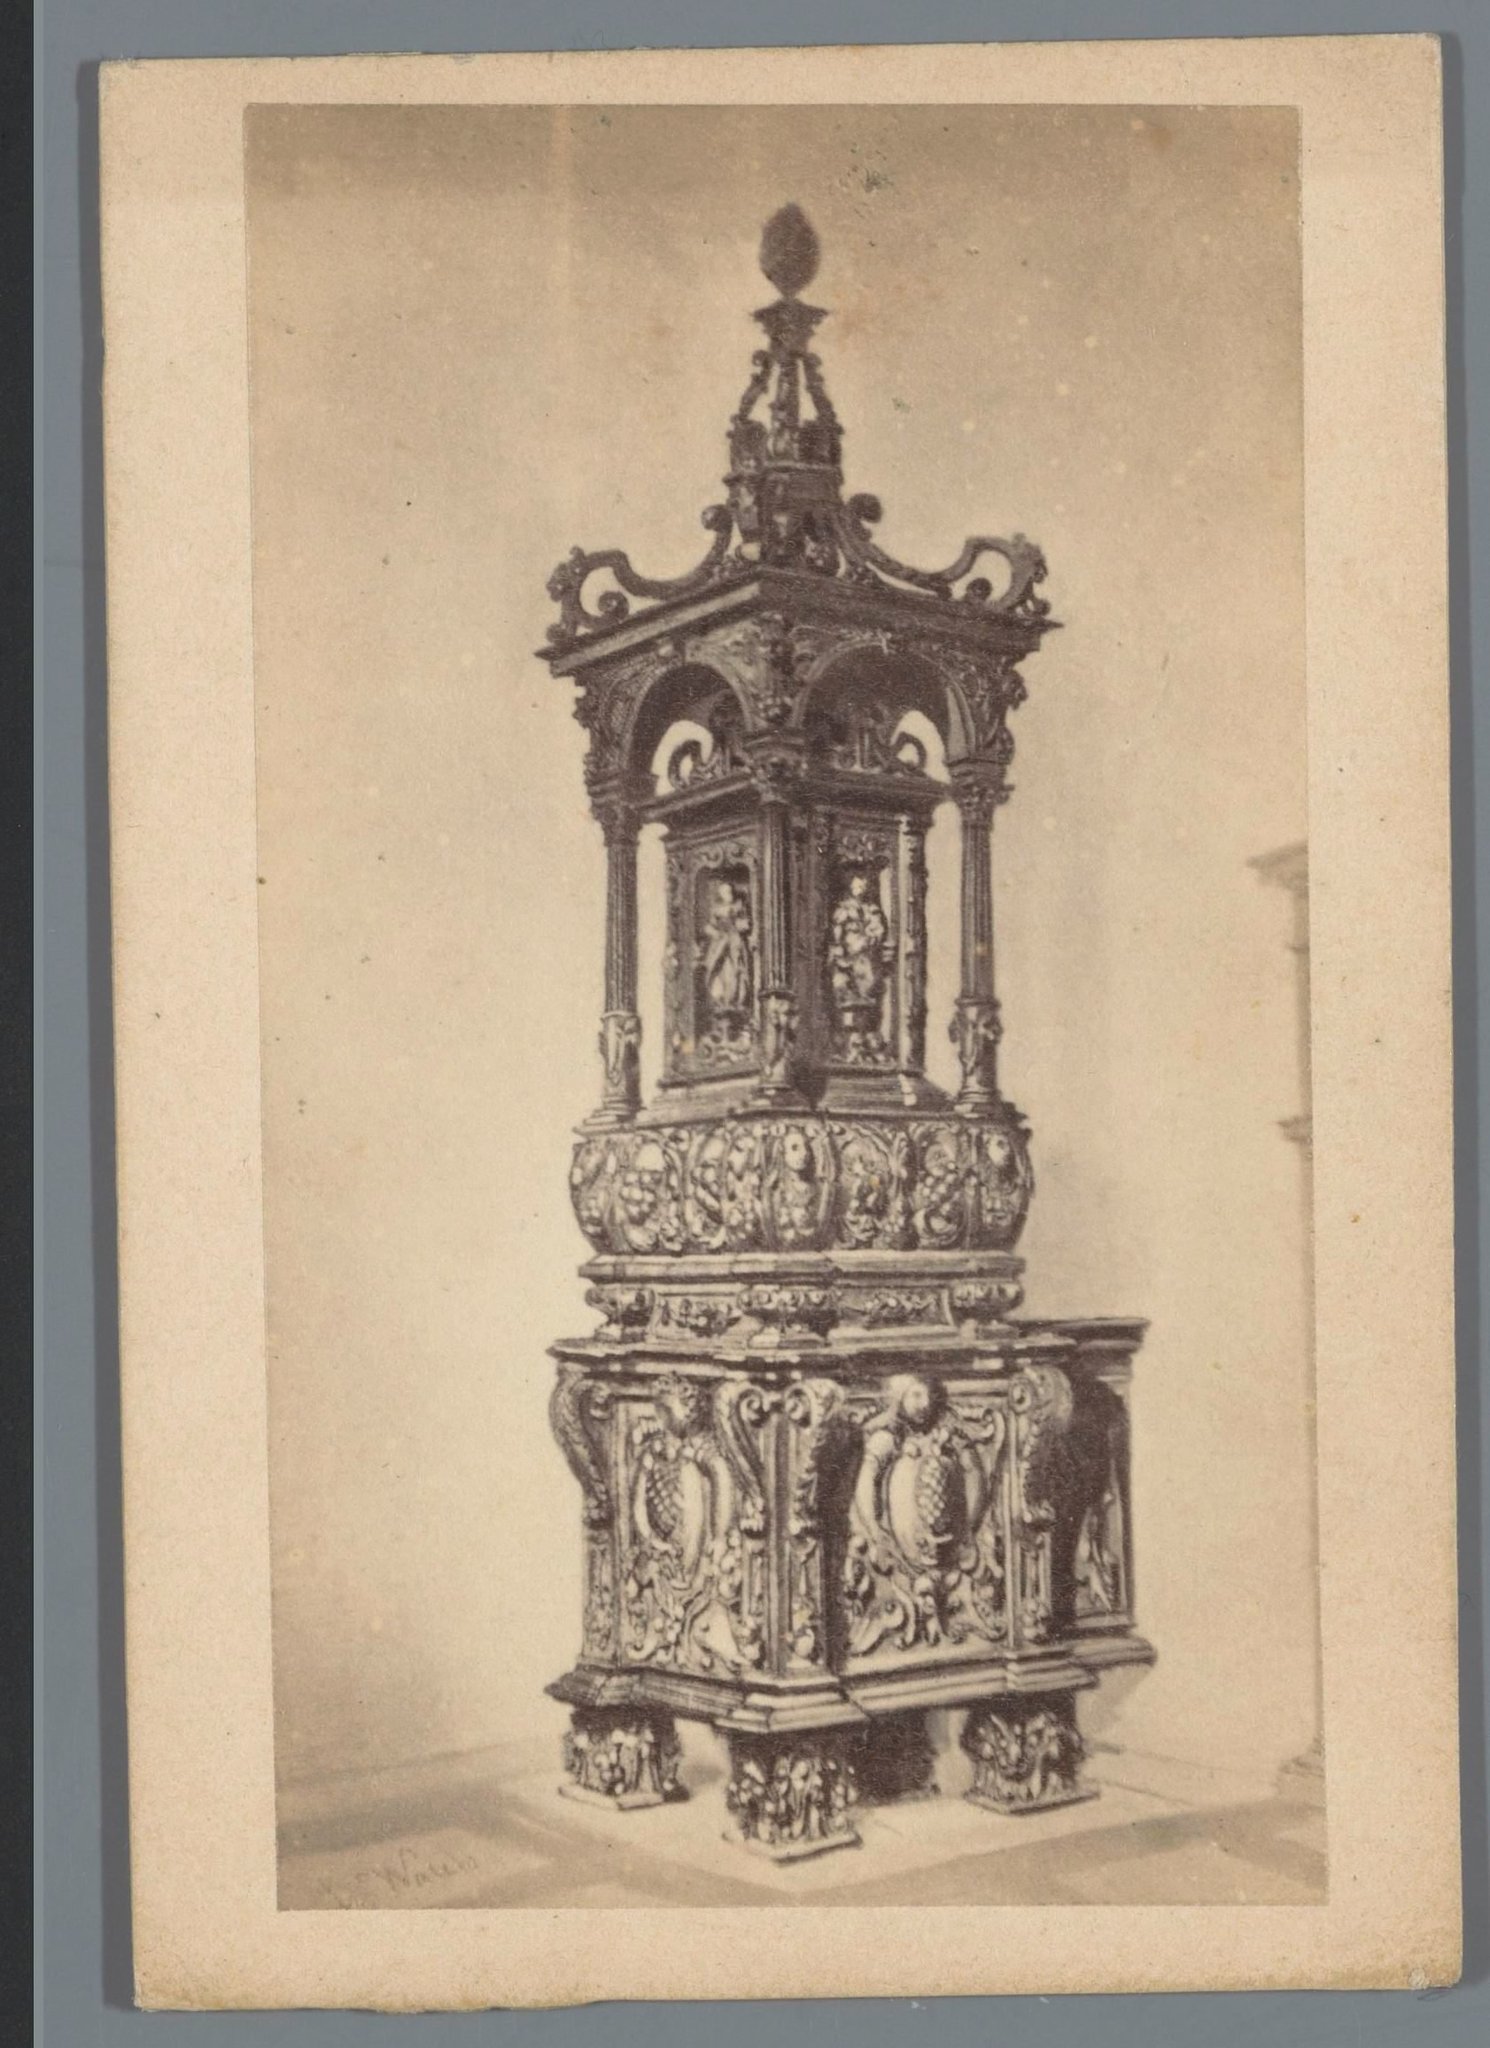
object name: reproduction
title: Augsburg, Rathhaus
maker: ferdinand brauer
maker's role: publisher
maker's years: -1915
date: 1855-1885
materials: cardboard, paper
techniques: albumen print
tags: relics (and reliquaries)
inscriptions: number: ‘18’